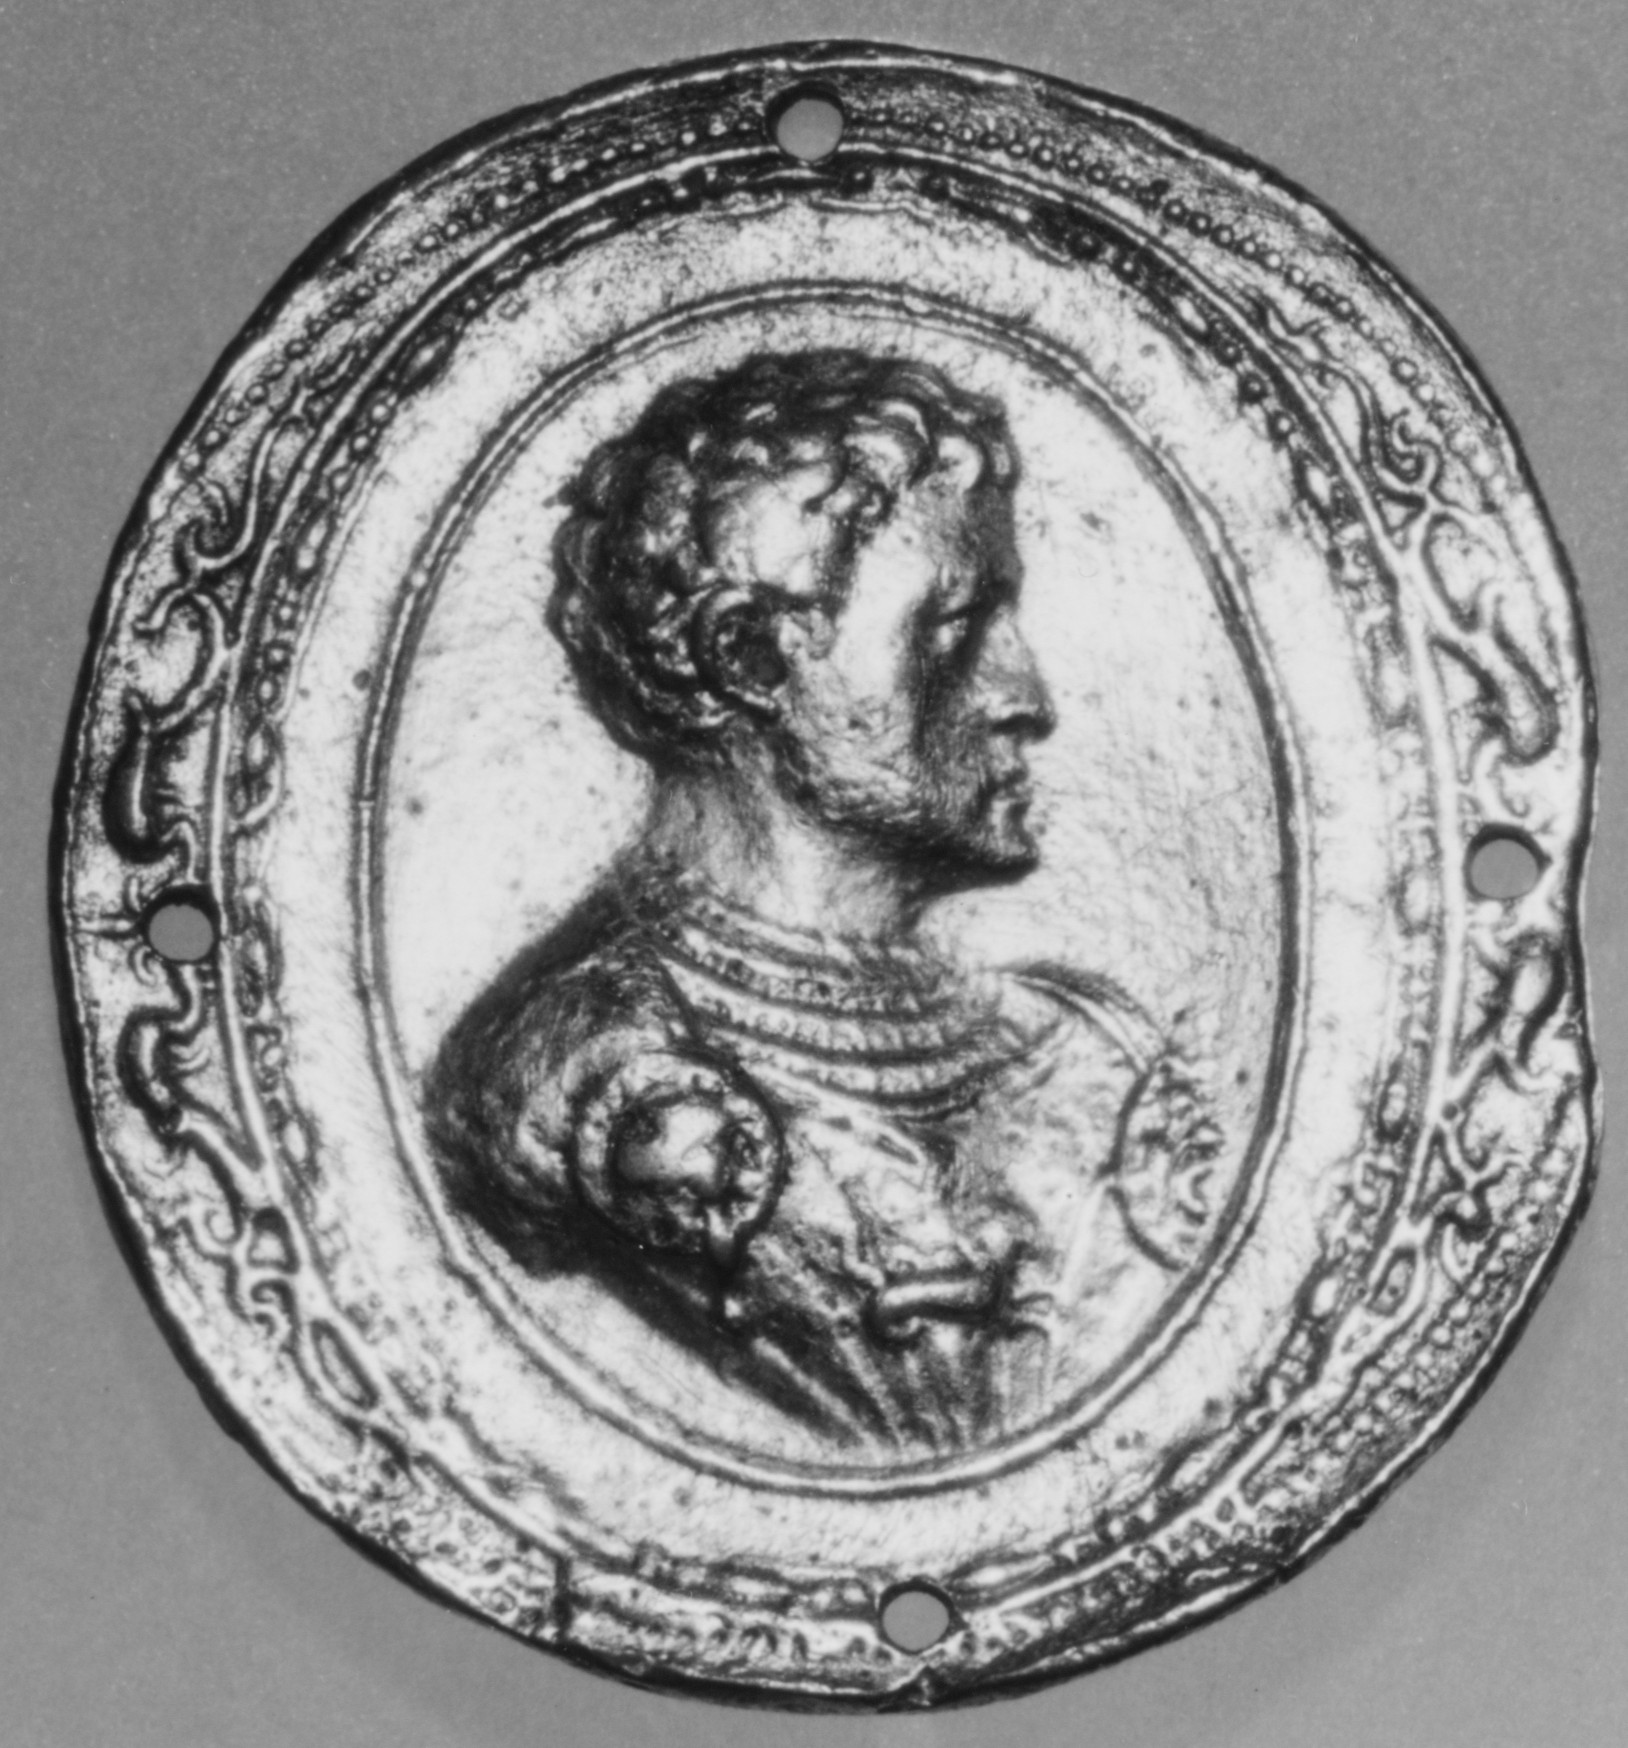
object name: medal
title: Cosimo I de' Medici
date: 1534-1566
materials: gilt bronze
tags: men,profiles